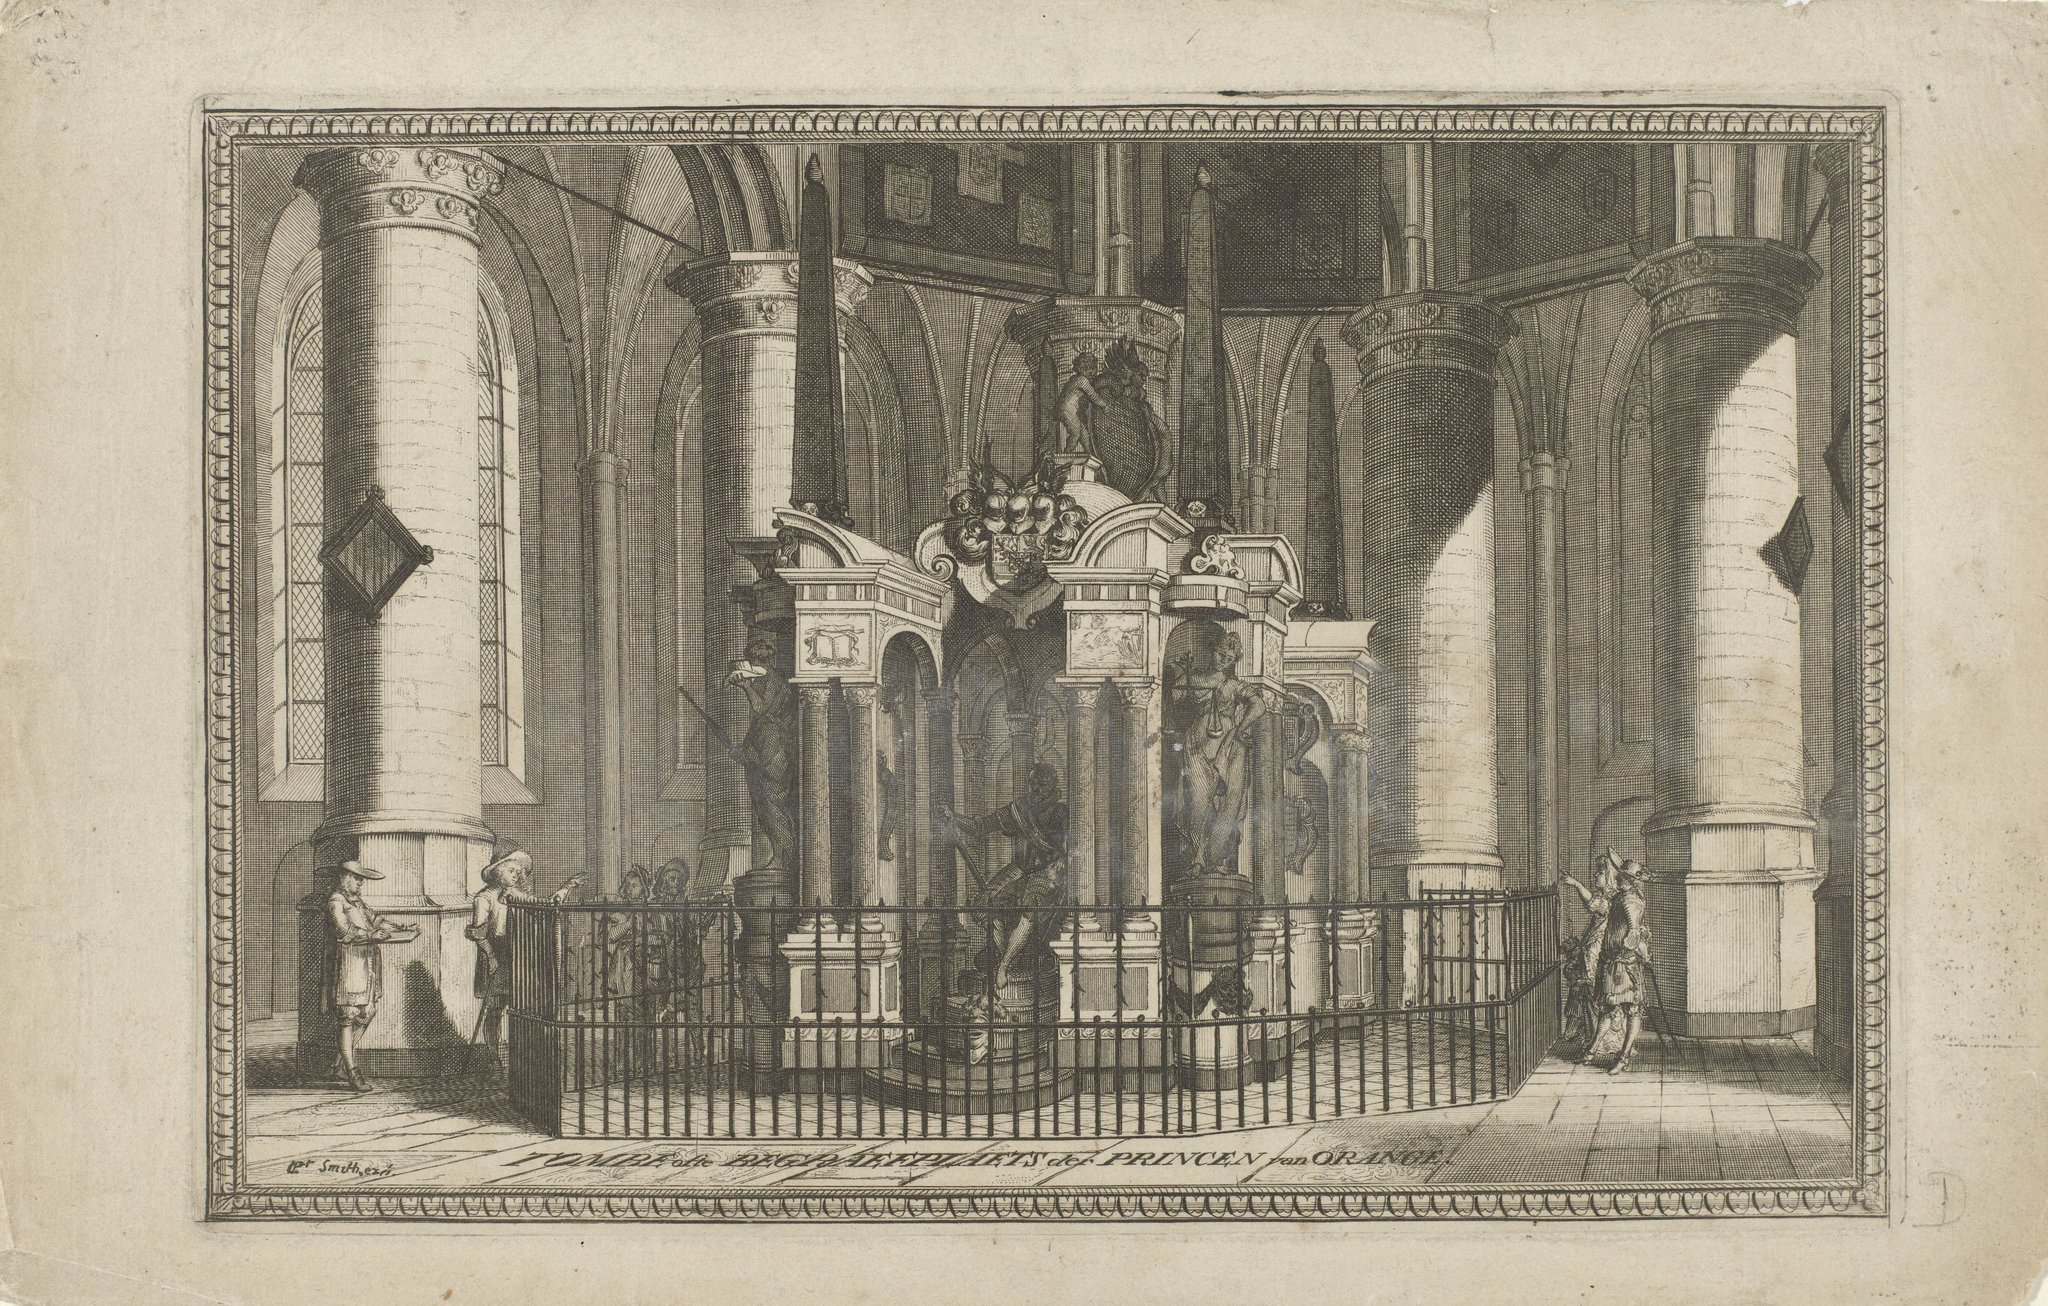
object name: print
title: Graftombe van Willem I, prins van Oranje, 1623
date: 1700-1799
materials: paper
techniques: etching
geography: low countries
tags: delft, william i (prince of orange), historical persons, interior of church, grave-building, monumental tomb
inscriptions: collector's mark: Lugt 2228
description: De hier vermelde titel verwijst naar de hoogst verkregen titel van de geportretteerde, niet per se naar de titel die de geportretteerde op deze voorstelling draagt.